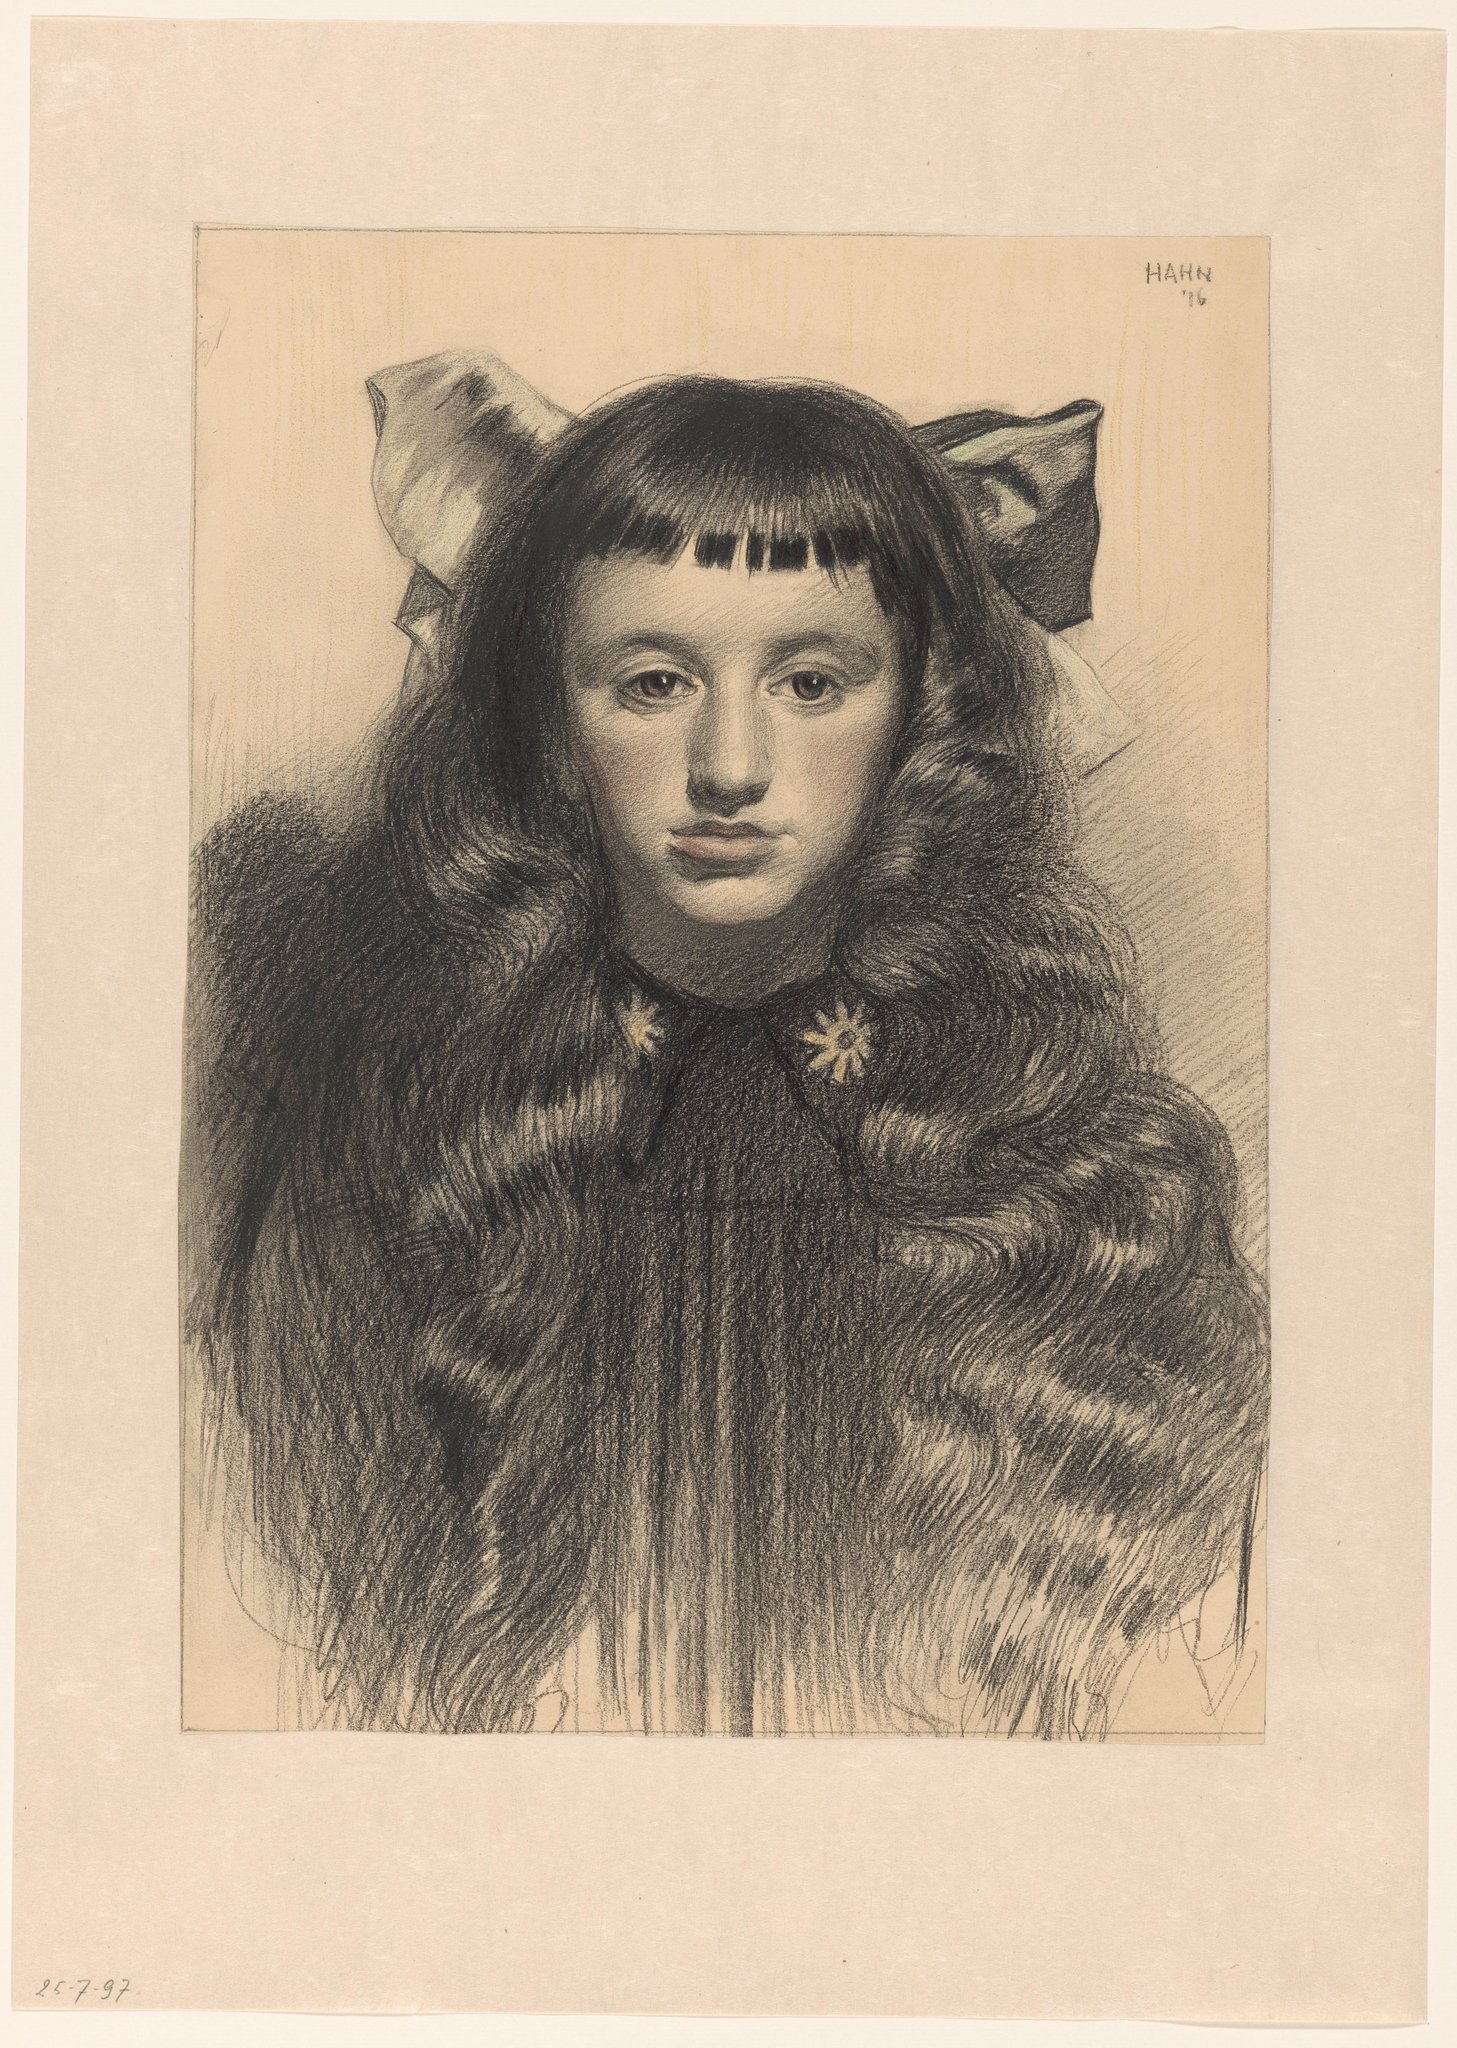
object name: drawing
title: Portret van een meisje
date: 1916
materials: chalk, paper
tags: anonymous historical person portrayed alone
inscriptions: date: ‘'16’